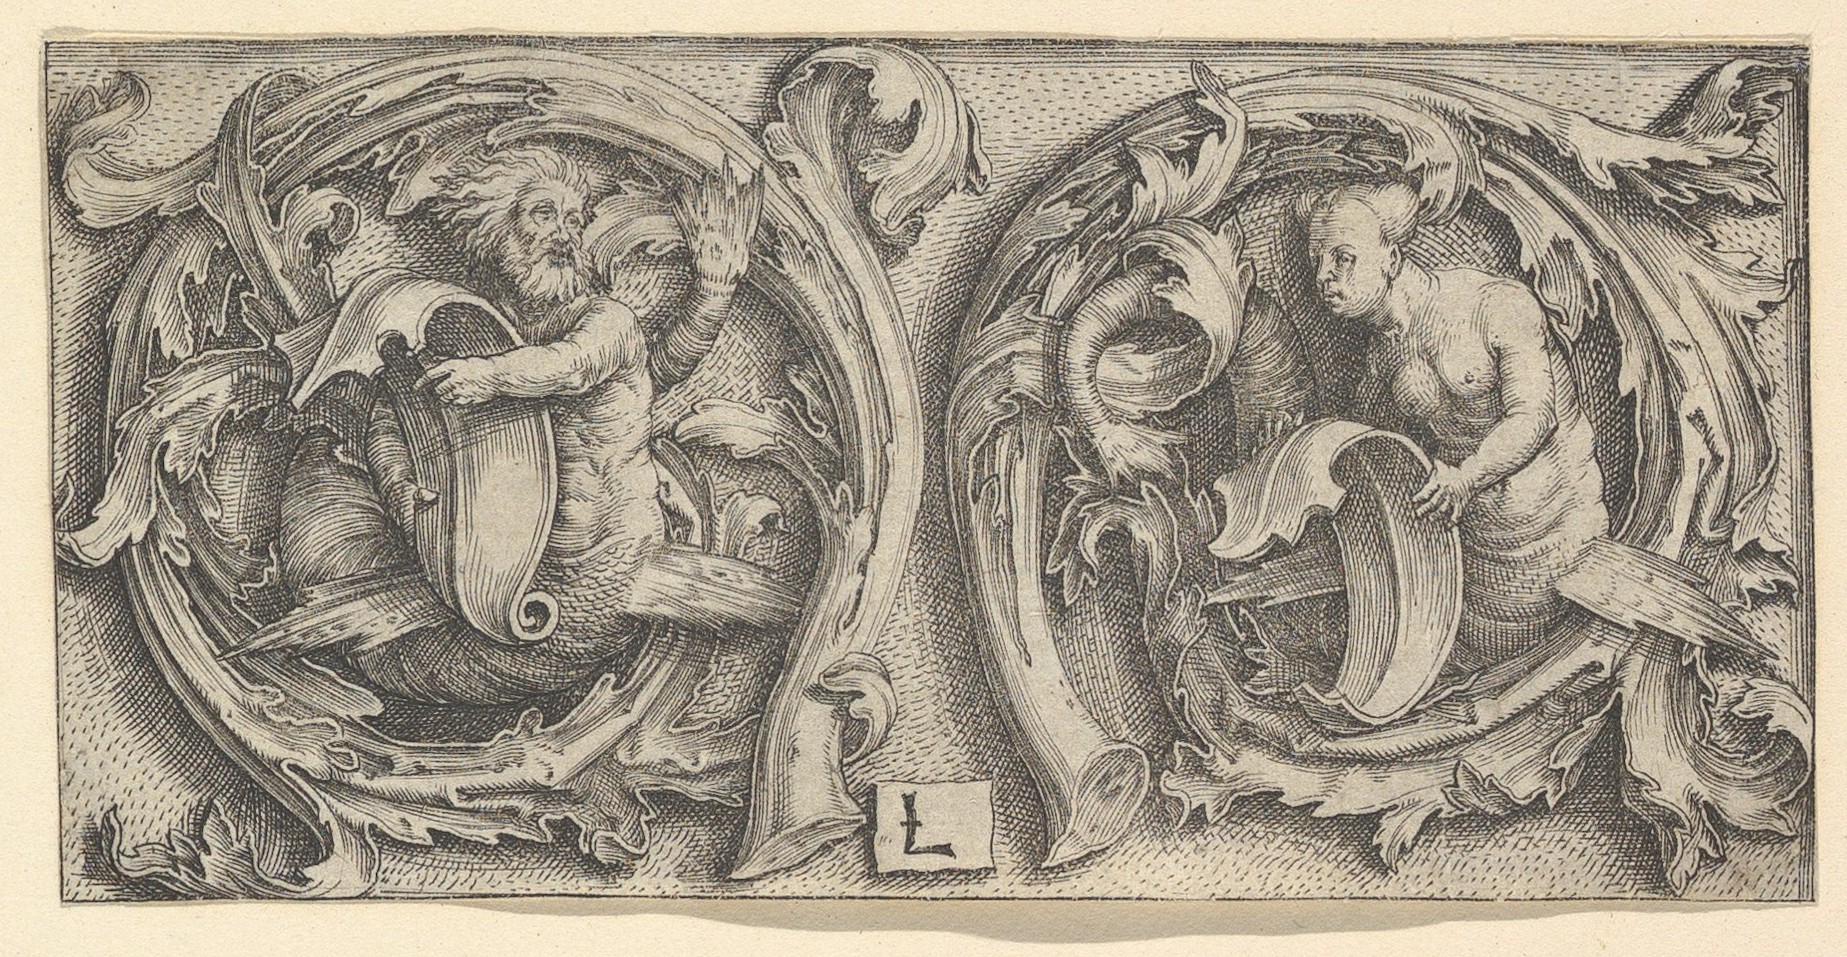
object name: print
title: Triton and Siren in Tendrils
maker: lucas van leyden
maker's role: artist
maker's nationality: netherlandish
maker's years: 1494-1533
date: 1510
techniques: engraving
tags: triton